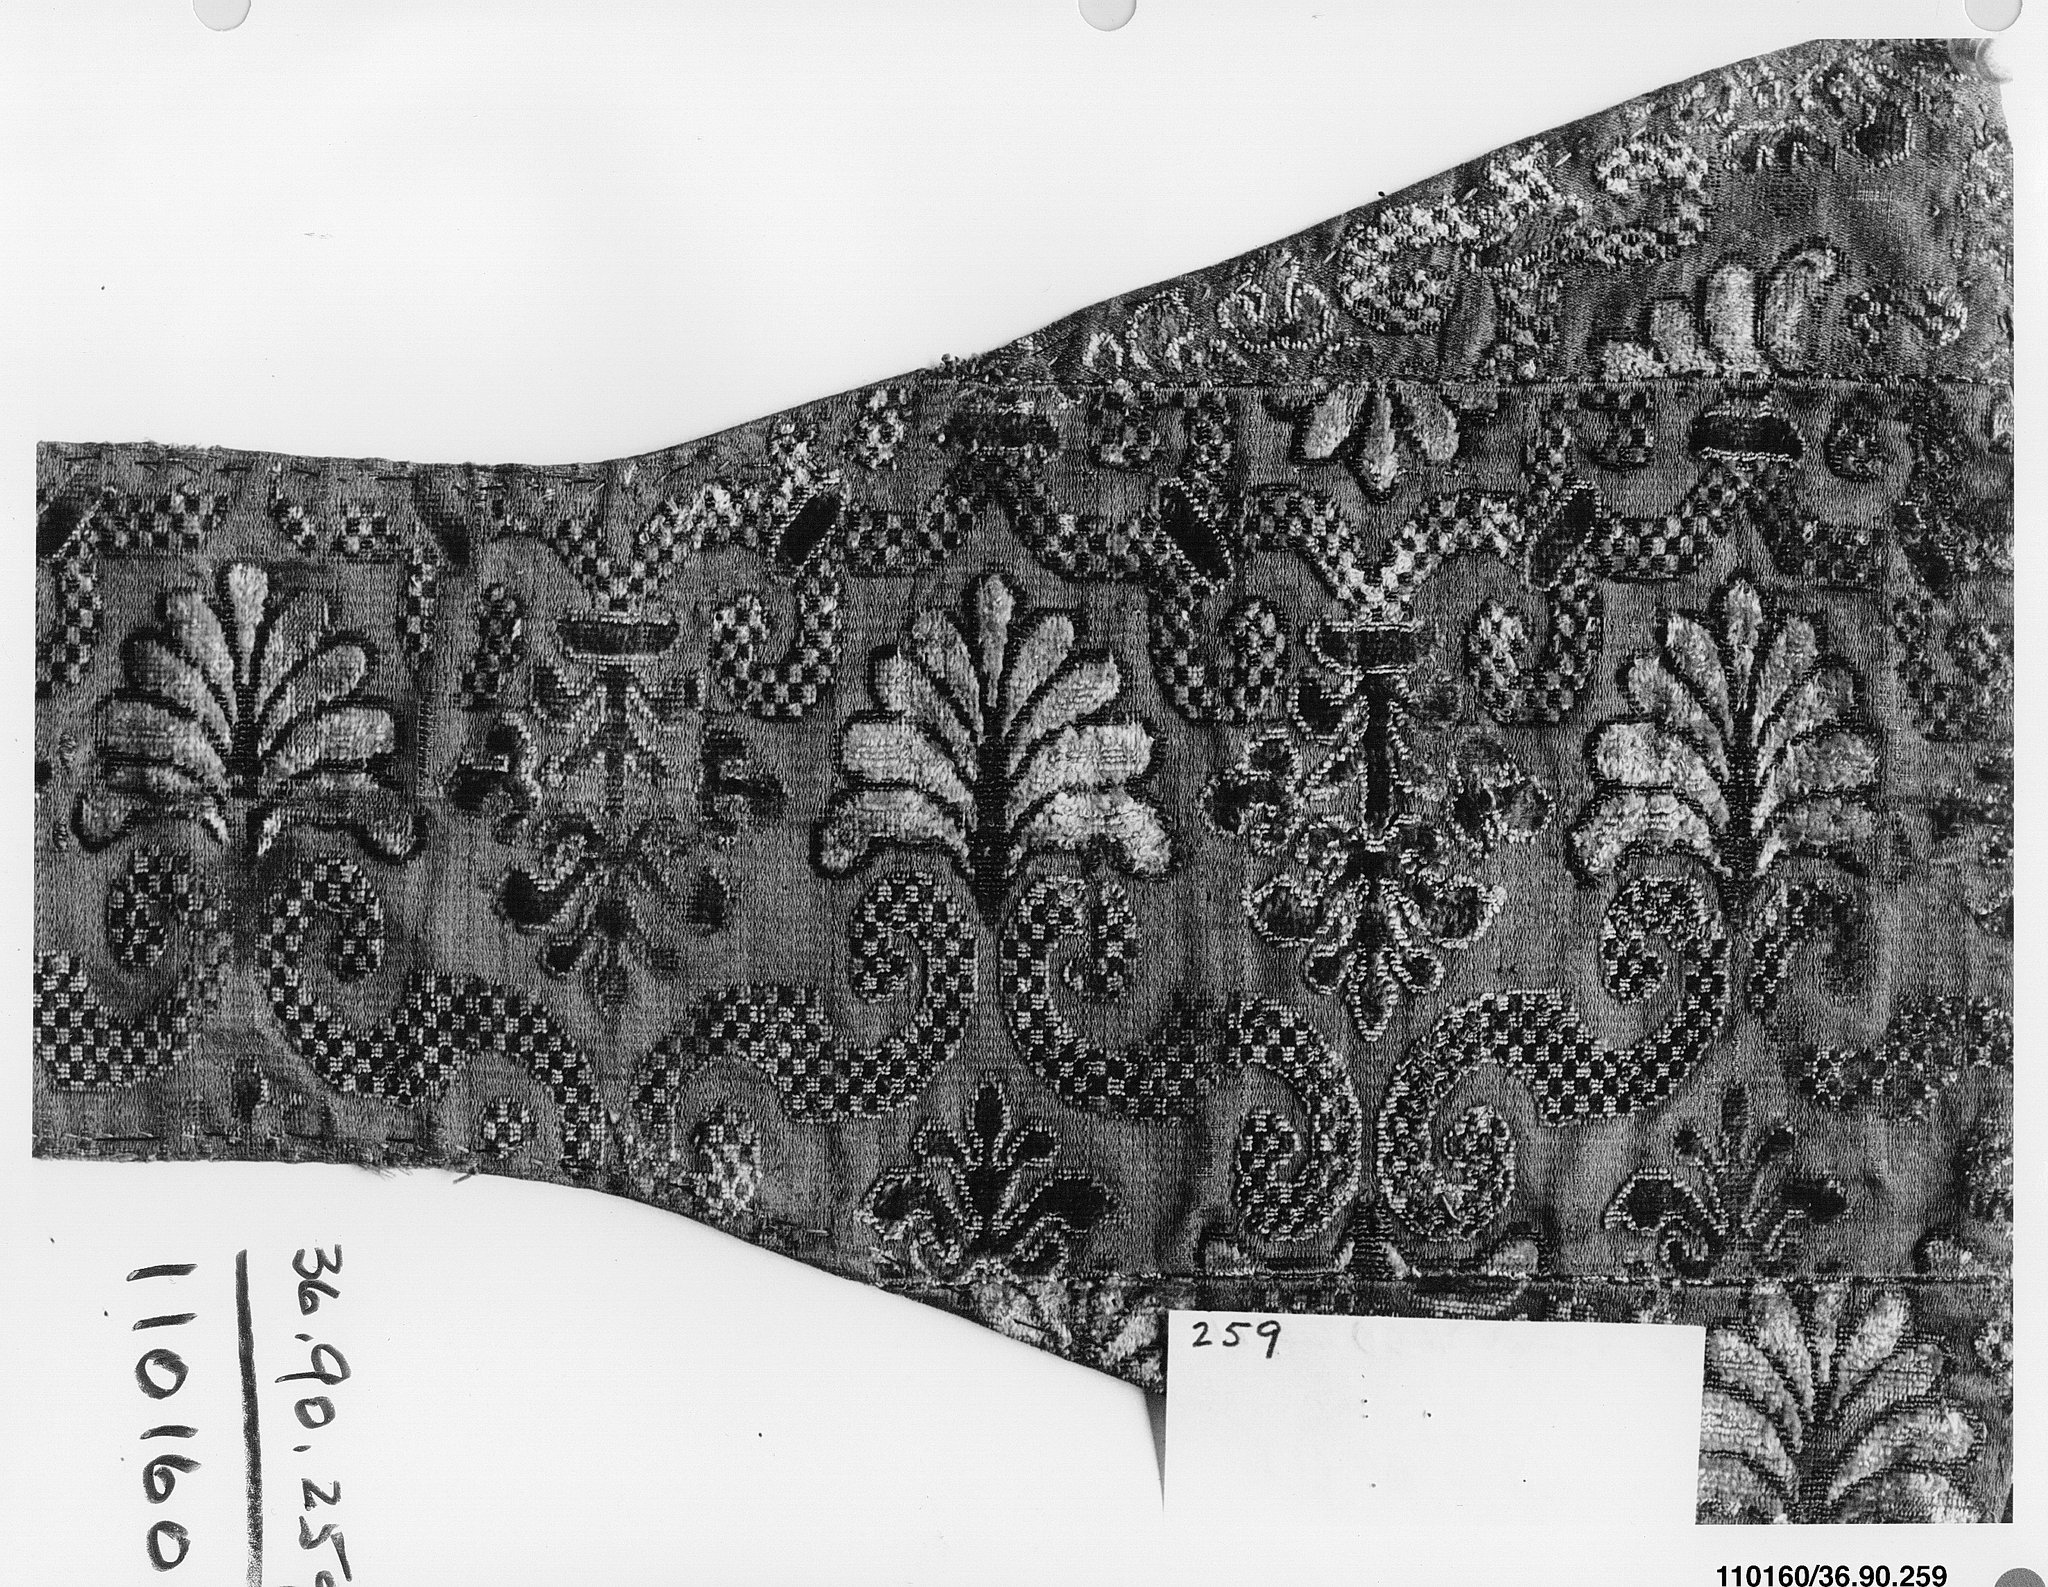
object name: piece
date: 1501-1700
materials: silk